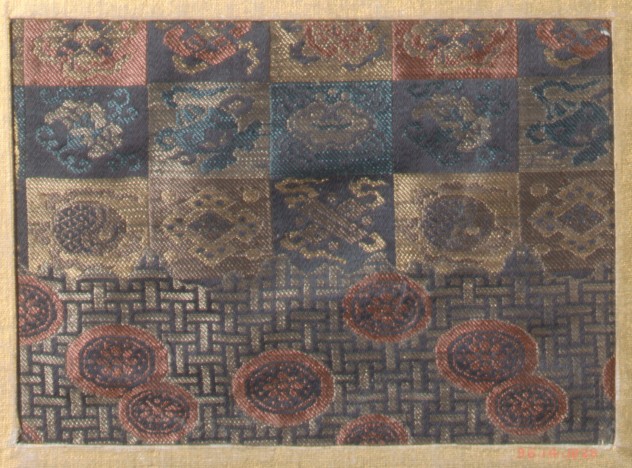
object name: piece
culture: japanese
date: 1701-1900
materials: silk